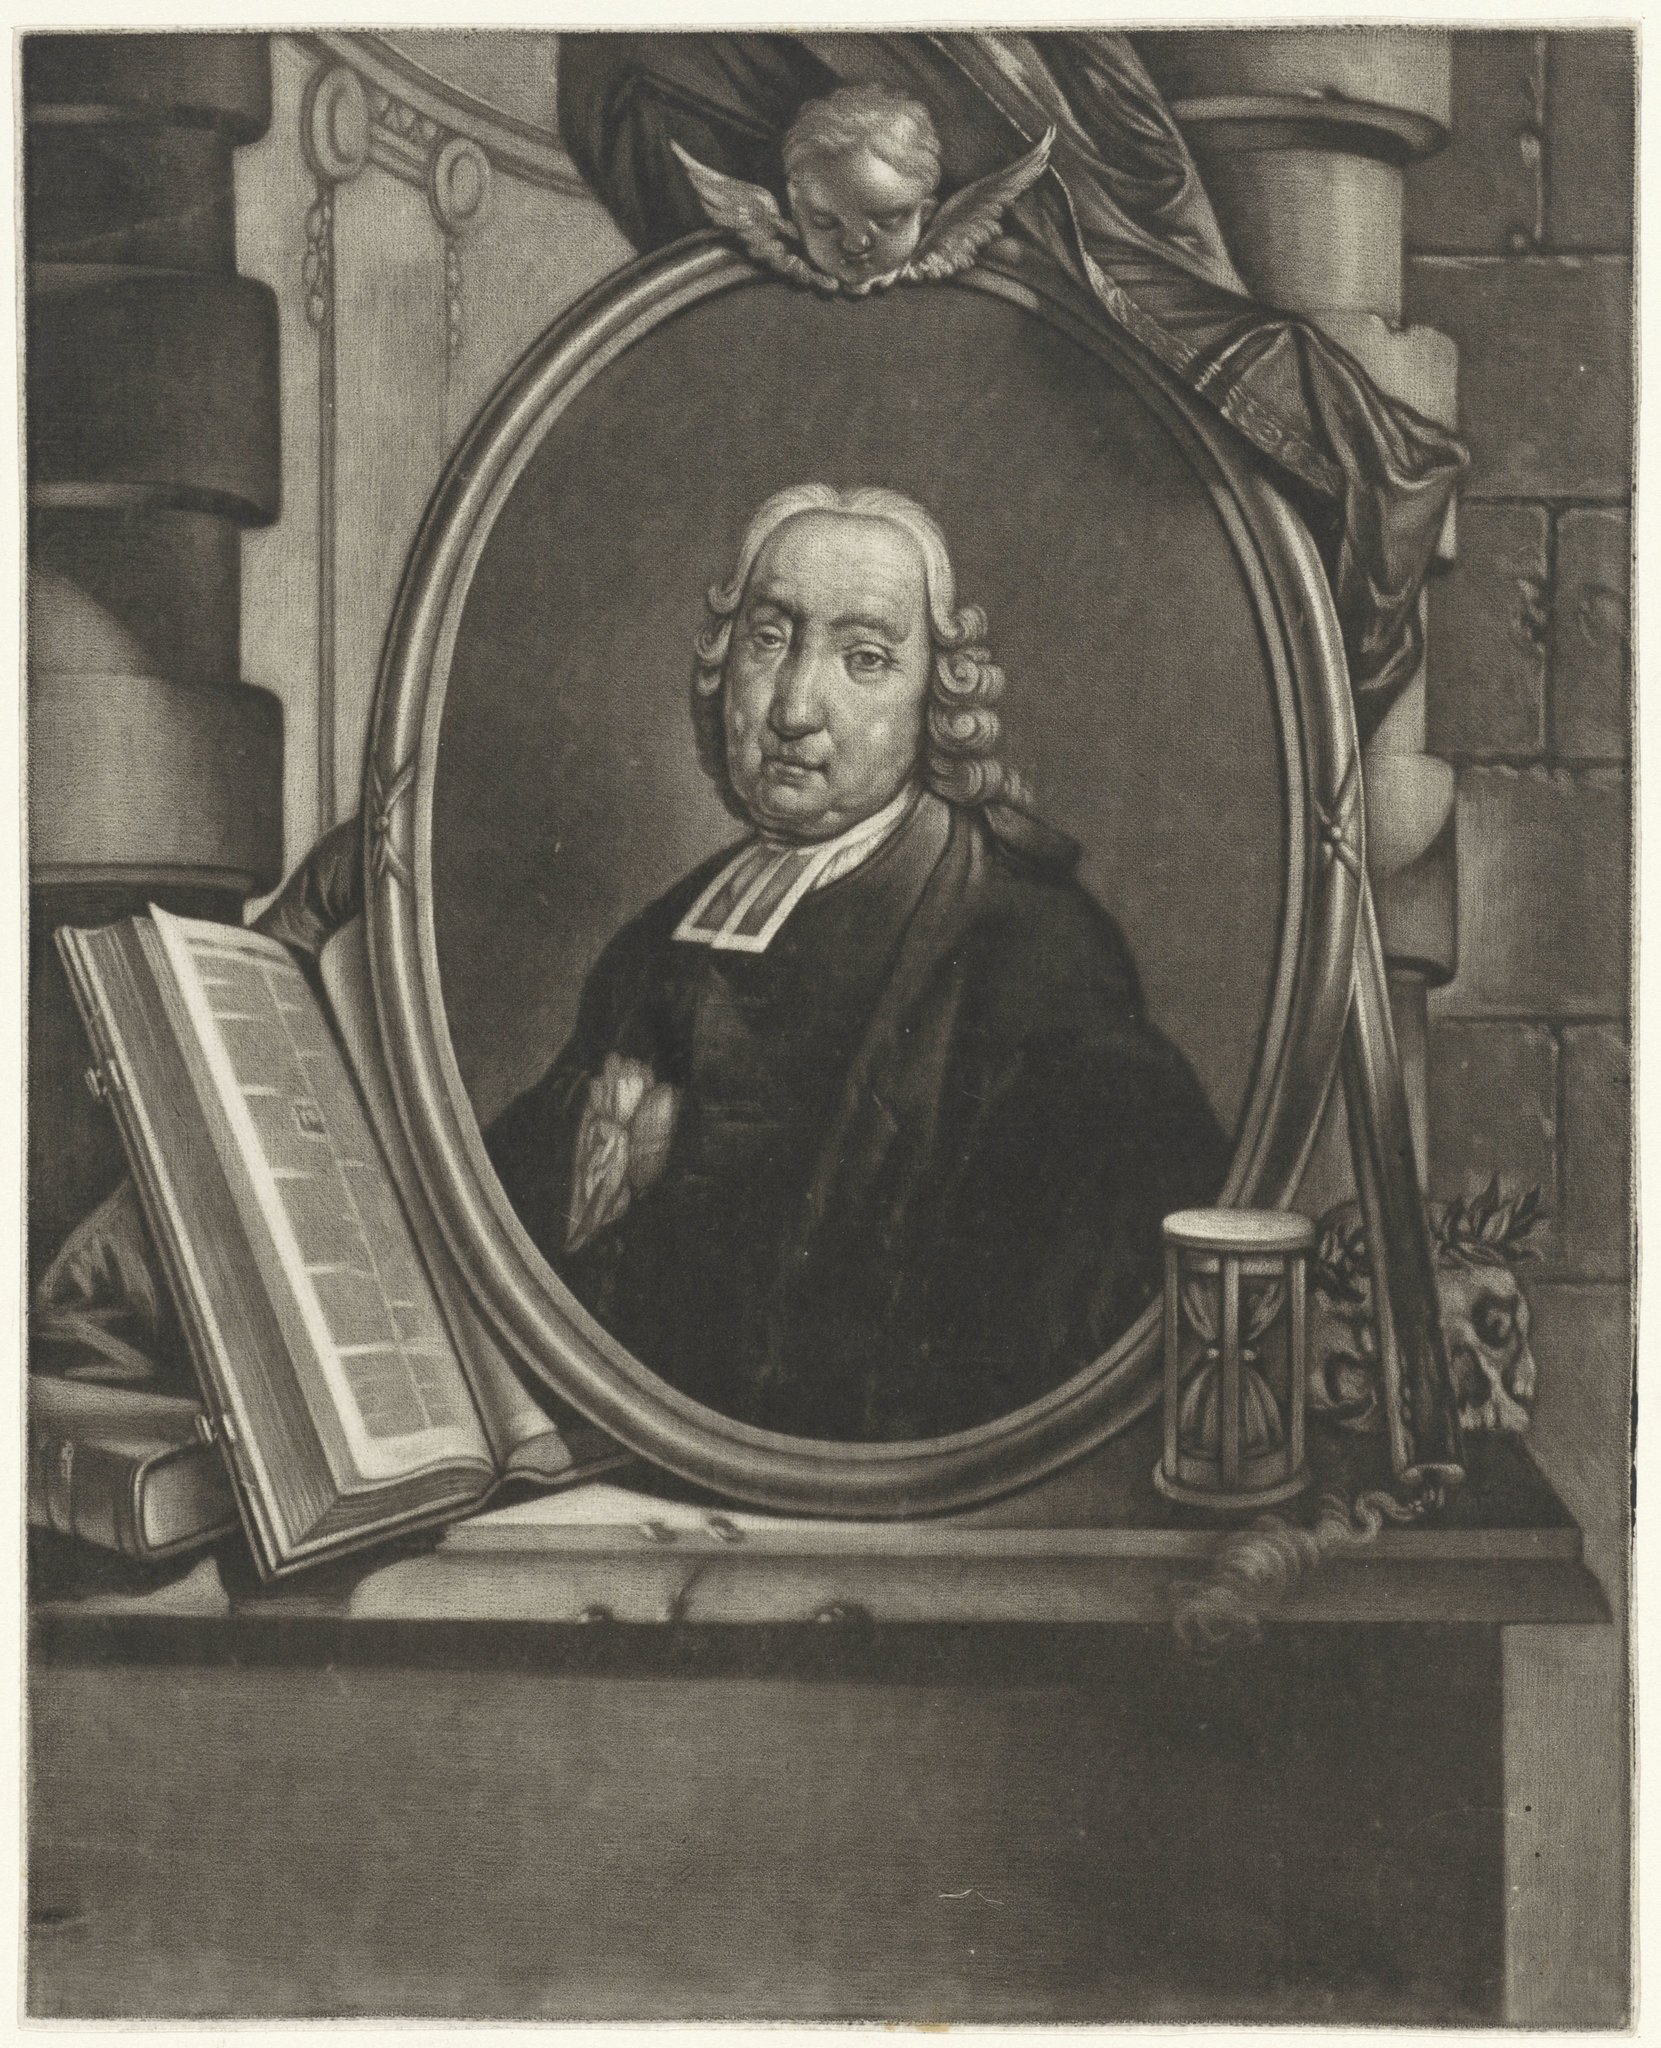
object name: print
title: Portret van Petrus van Ede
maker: jan stolker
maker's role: draughtsman, painter, print maker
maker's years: 1724-1785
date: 1759-1785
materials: paper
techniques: mezzotint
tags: historical persons, 'vanitas' symbols, hourglass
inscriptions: collector's mark: Lugt 240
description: Petrus van Ede, predikant te Rotterdam. Om de omlijsting verschillende vanitassymbolen zoals een gedoofde kaars, een zandloper en een gelauwerde schedel.